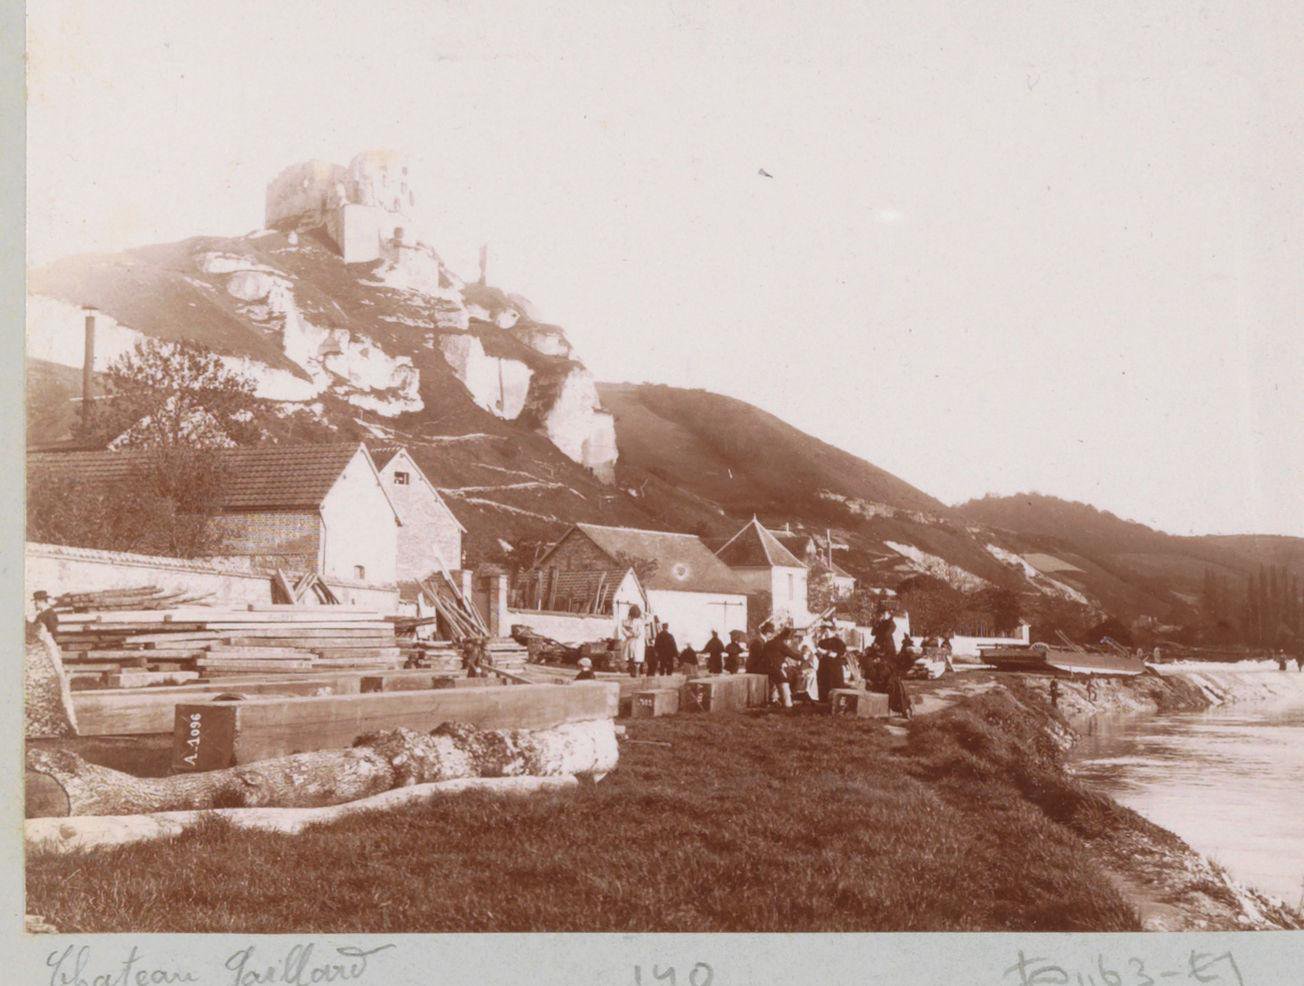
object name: photograph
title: Mensen bij een houtzagerij in Les Andelys met linksboven de ruïne van Château Gaillard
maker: delizy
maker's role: manufacturer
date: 1897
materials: paper, photographic support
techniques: gelatin silver print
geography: les andelys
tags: prospect of village, silhouette of village, saw-mill (works), ruin of a dwelling, house, castle, etc.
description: Onderdeel van Fotoalbum van een Franse amateurfotograaf met opnames van uitstapjes in Frankrijk, Spanje, België, Luxemburg en Nederland, de eerste automobielen en autoraces.